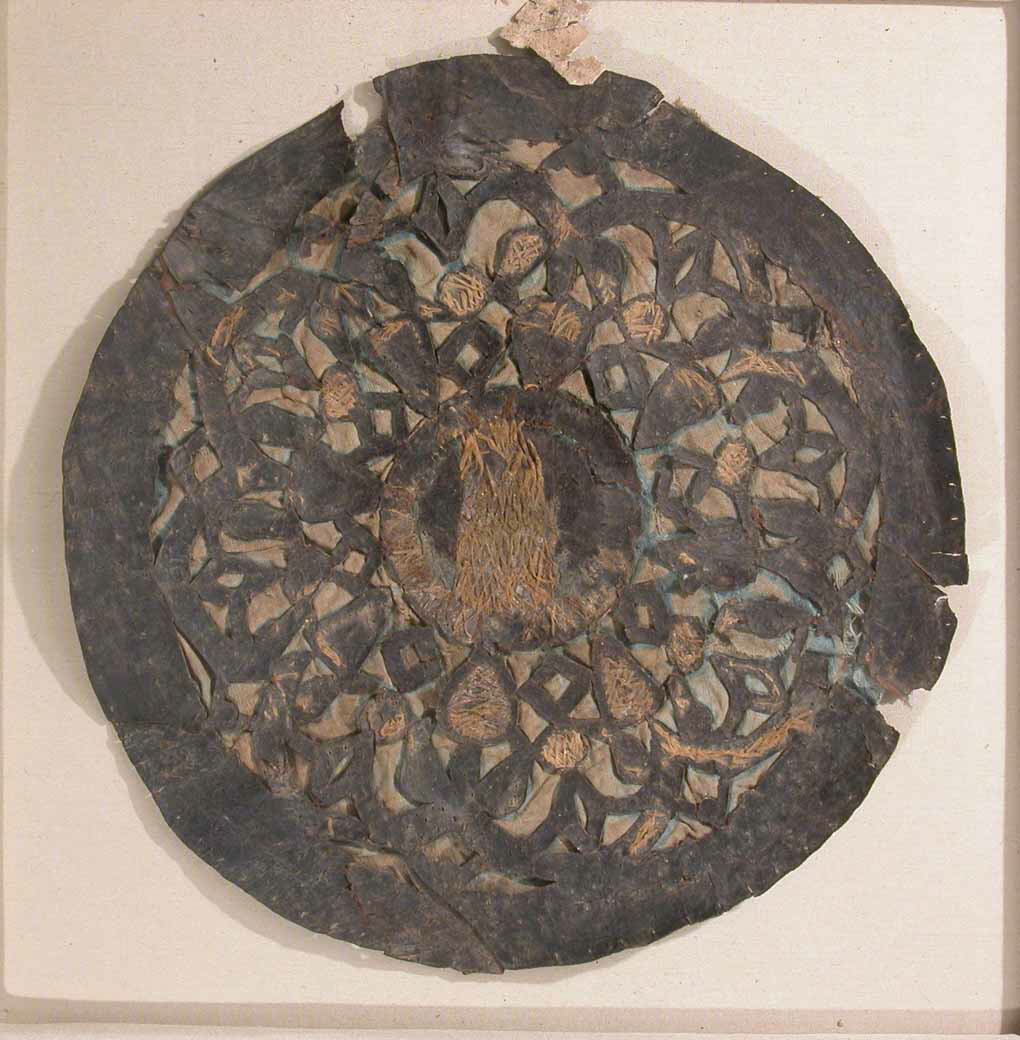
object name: medallion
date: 1301-1400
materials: cotton, leather, silk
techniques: embroidery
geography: egypt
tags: medallions